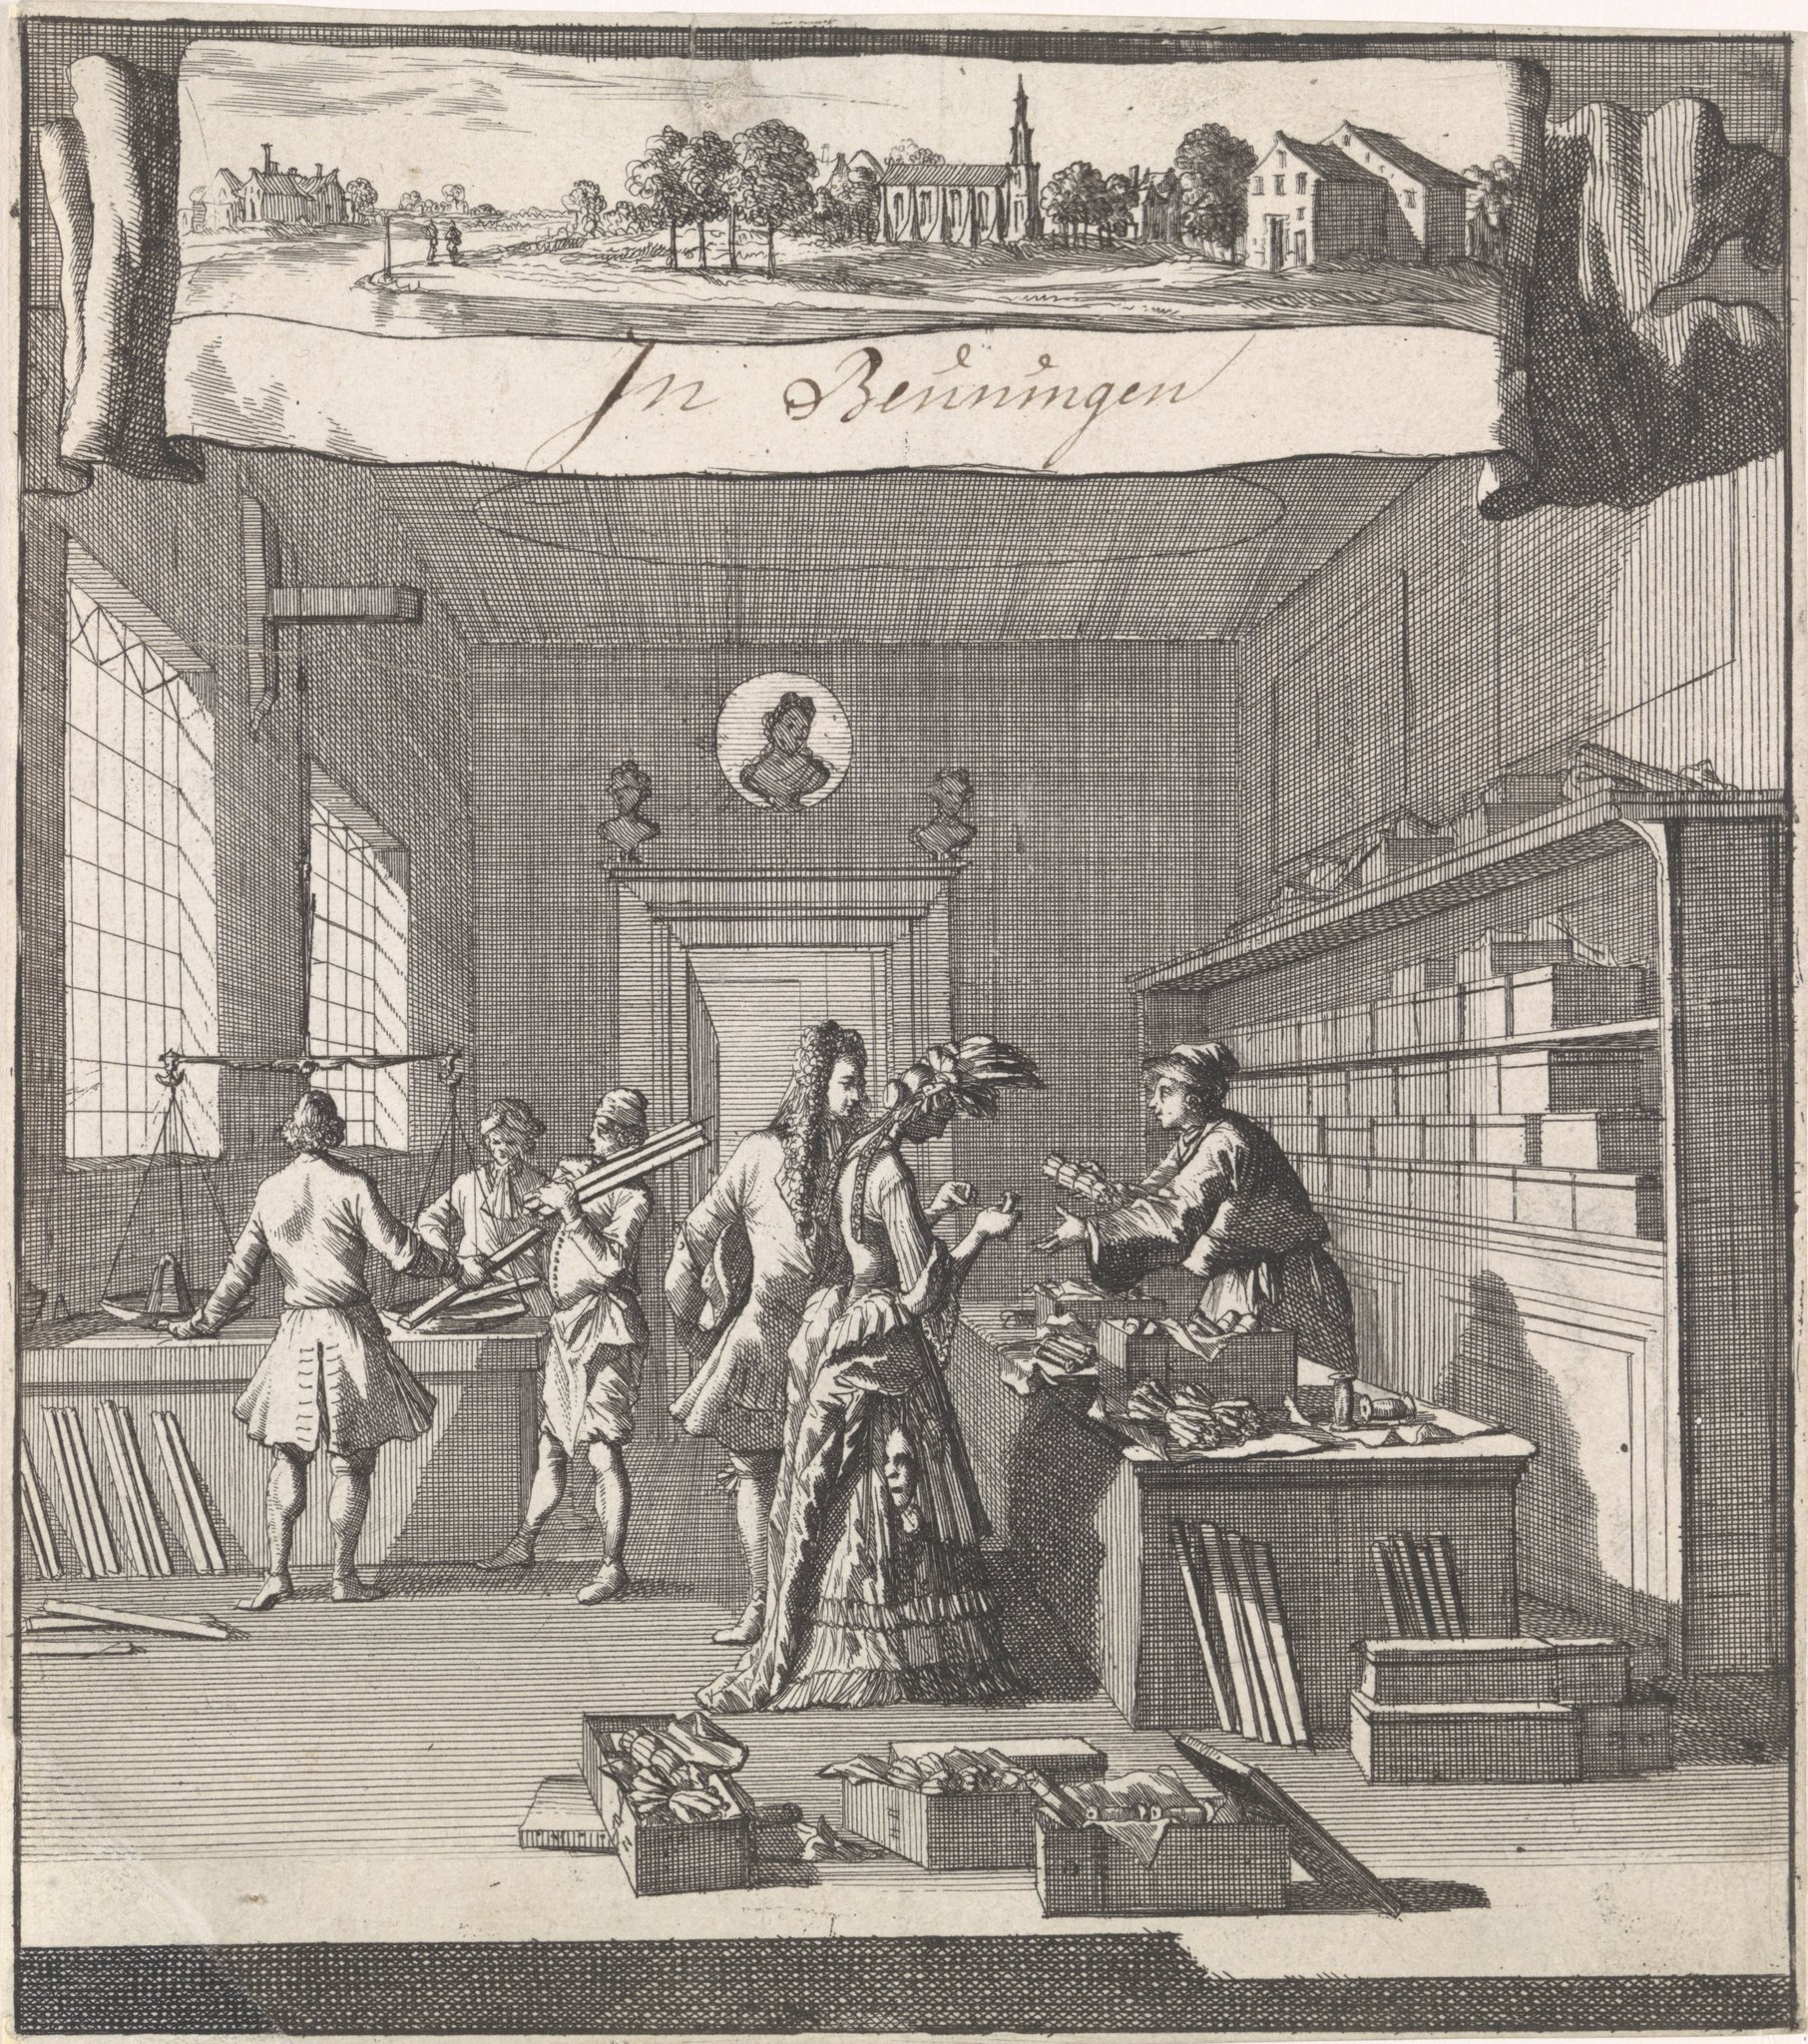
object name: print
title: Adreskaart voor de goud- en zilverdraadwinkel van Christiaan Beuning te Beuningen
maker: caspar luyken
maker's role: draughtsman, print maker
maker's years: 1672-1708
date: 1697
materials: paper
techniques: etching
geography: amsterdam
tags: shop, store, gold-thread embroidery (+ materials used for clothes), landscapes with waters, waterscapes, seascapes (in the temperate zone), spinning (manufacture of yarn)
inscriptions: collector's mark: Lugt 2228, inscription: ‘In Beuningen’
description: Adreskaart voor de goud- en zilverdraadwinkel van Christiaan Beuning te Beuningen. Interieur van een winkel waar rechts een echtpaar aan de toonbank draden uitzoekt. Links wegen drie bedienden lange klossen af. Op een banderol boven deze voorstelling een weergave van de gemeente Beuningen, gelegen aan de Waal.